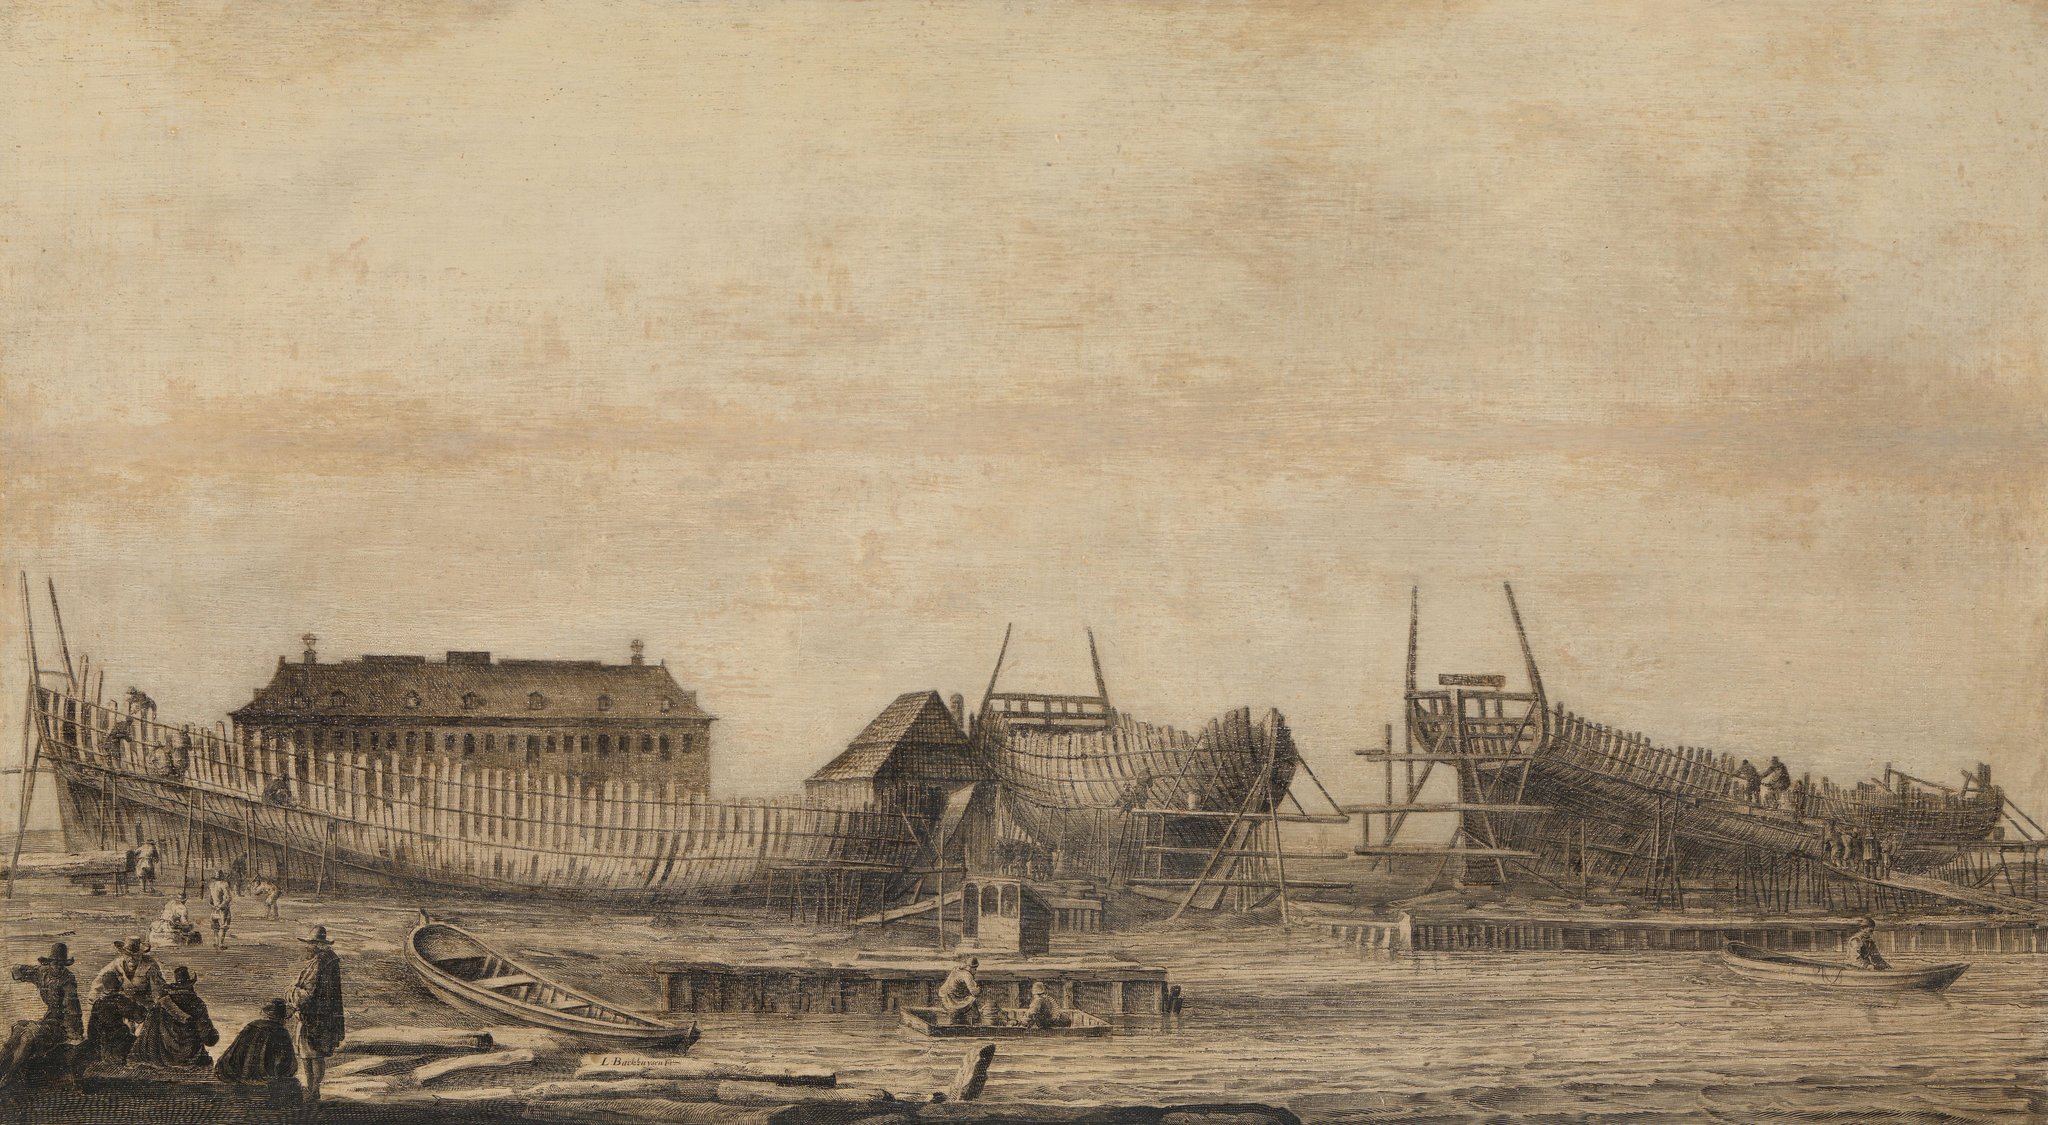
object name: penschildering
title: The Shipyard of the Amsterdam Admiralty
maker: ludolf bakhuysen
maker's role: draughtsman, print maker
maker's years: 1631-1708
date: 1655-1660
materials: ink, panel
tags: scaffolding ~ shipbuilding, pier, quay, wharf, amsterdam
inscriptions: signature: ‘L. Backhuysen Ft.’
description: The shipyard of the Amsterdam Admiralty by Ludolf Bakhuysen, c. 1660 Three man-of-war are under construction in the Admiralty shipyard. In the background is the central depot where provisions for the fleet were stored. After 1650 the harbourcomplex at Amsterdam was extended for the Admiralty, which had one of the largest workforces in the city.